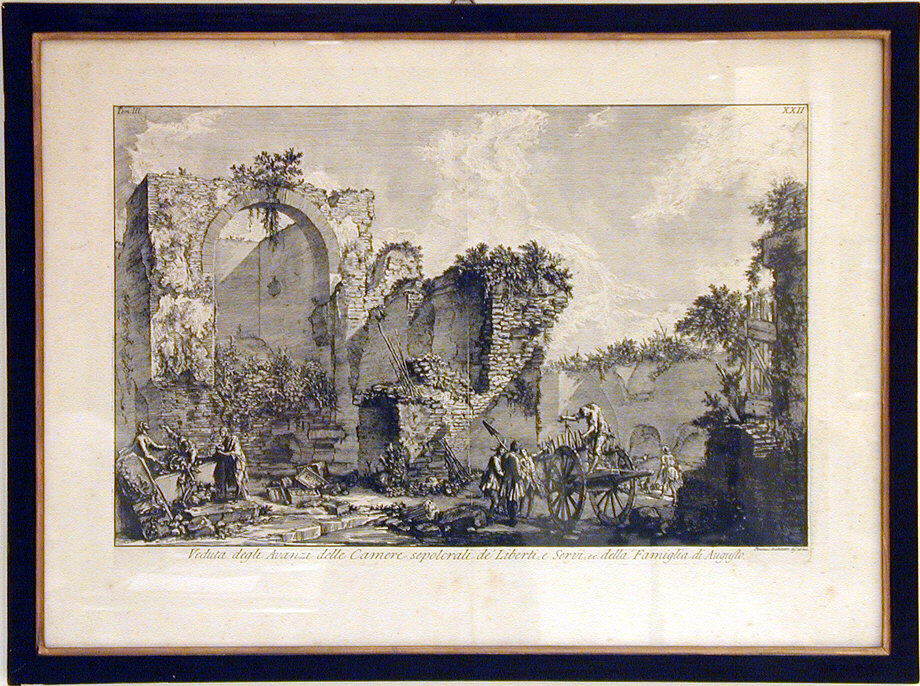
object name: six engraving and one map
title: Six engravings and one map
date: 1701-1800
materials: ink, paper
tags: ruins,maps